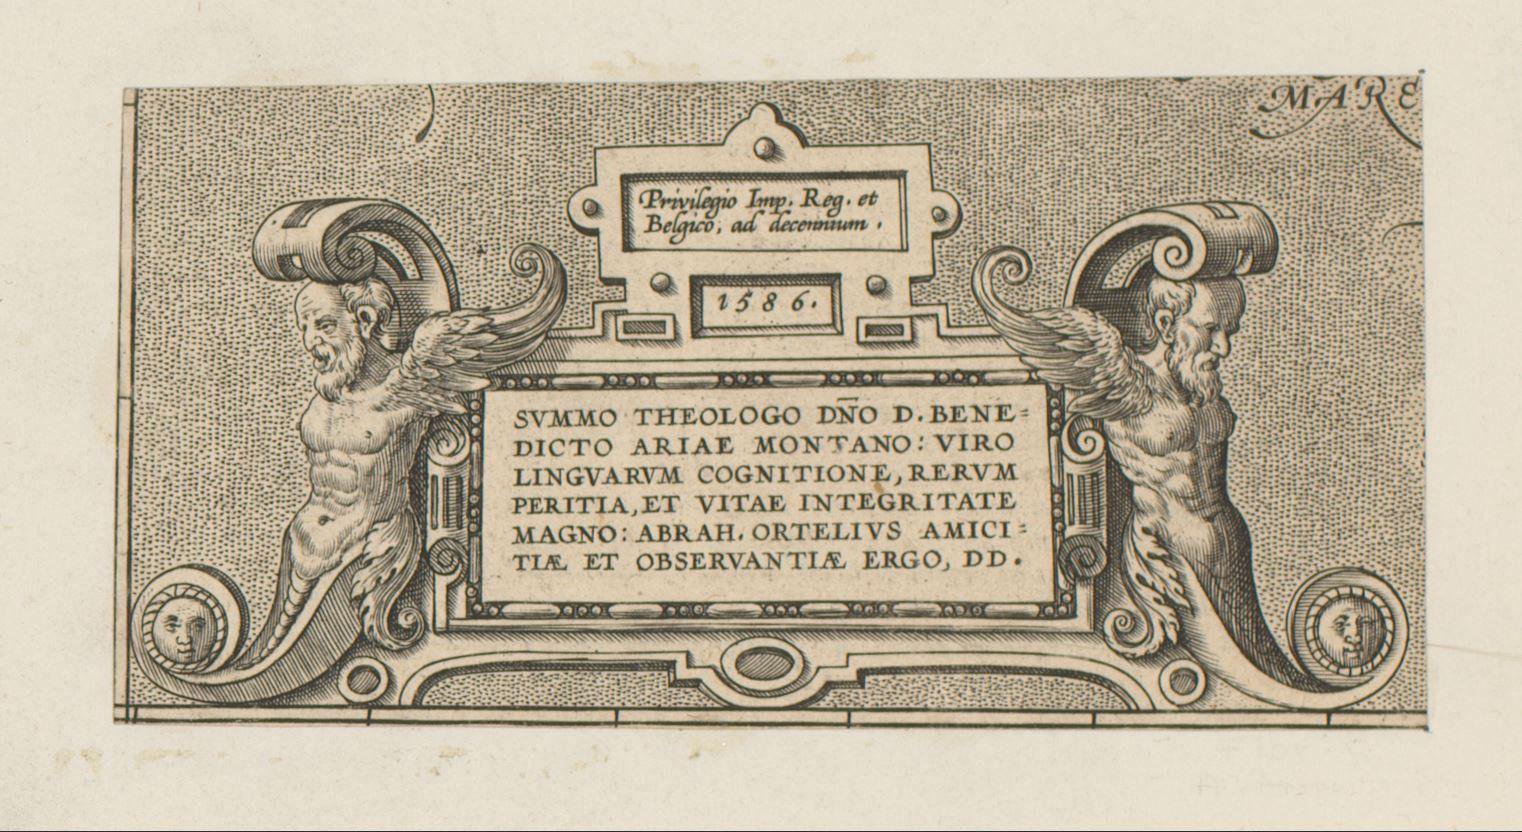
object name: print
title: Hispaniae Veteris Descriptio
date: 1586-1590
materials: paper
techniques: engraving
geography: antwerp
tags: herms (garden ornaments), ornament ~ cartouche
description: Rechthoekige cartouches geflankeerd door twee hermen met vleugels en opgerolde sokkels. De cartouche is een fragment van een kaart van Spanje. De prent maakt deel uit van een album.